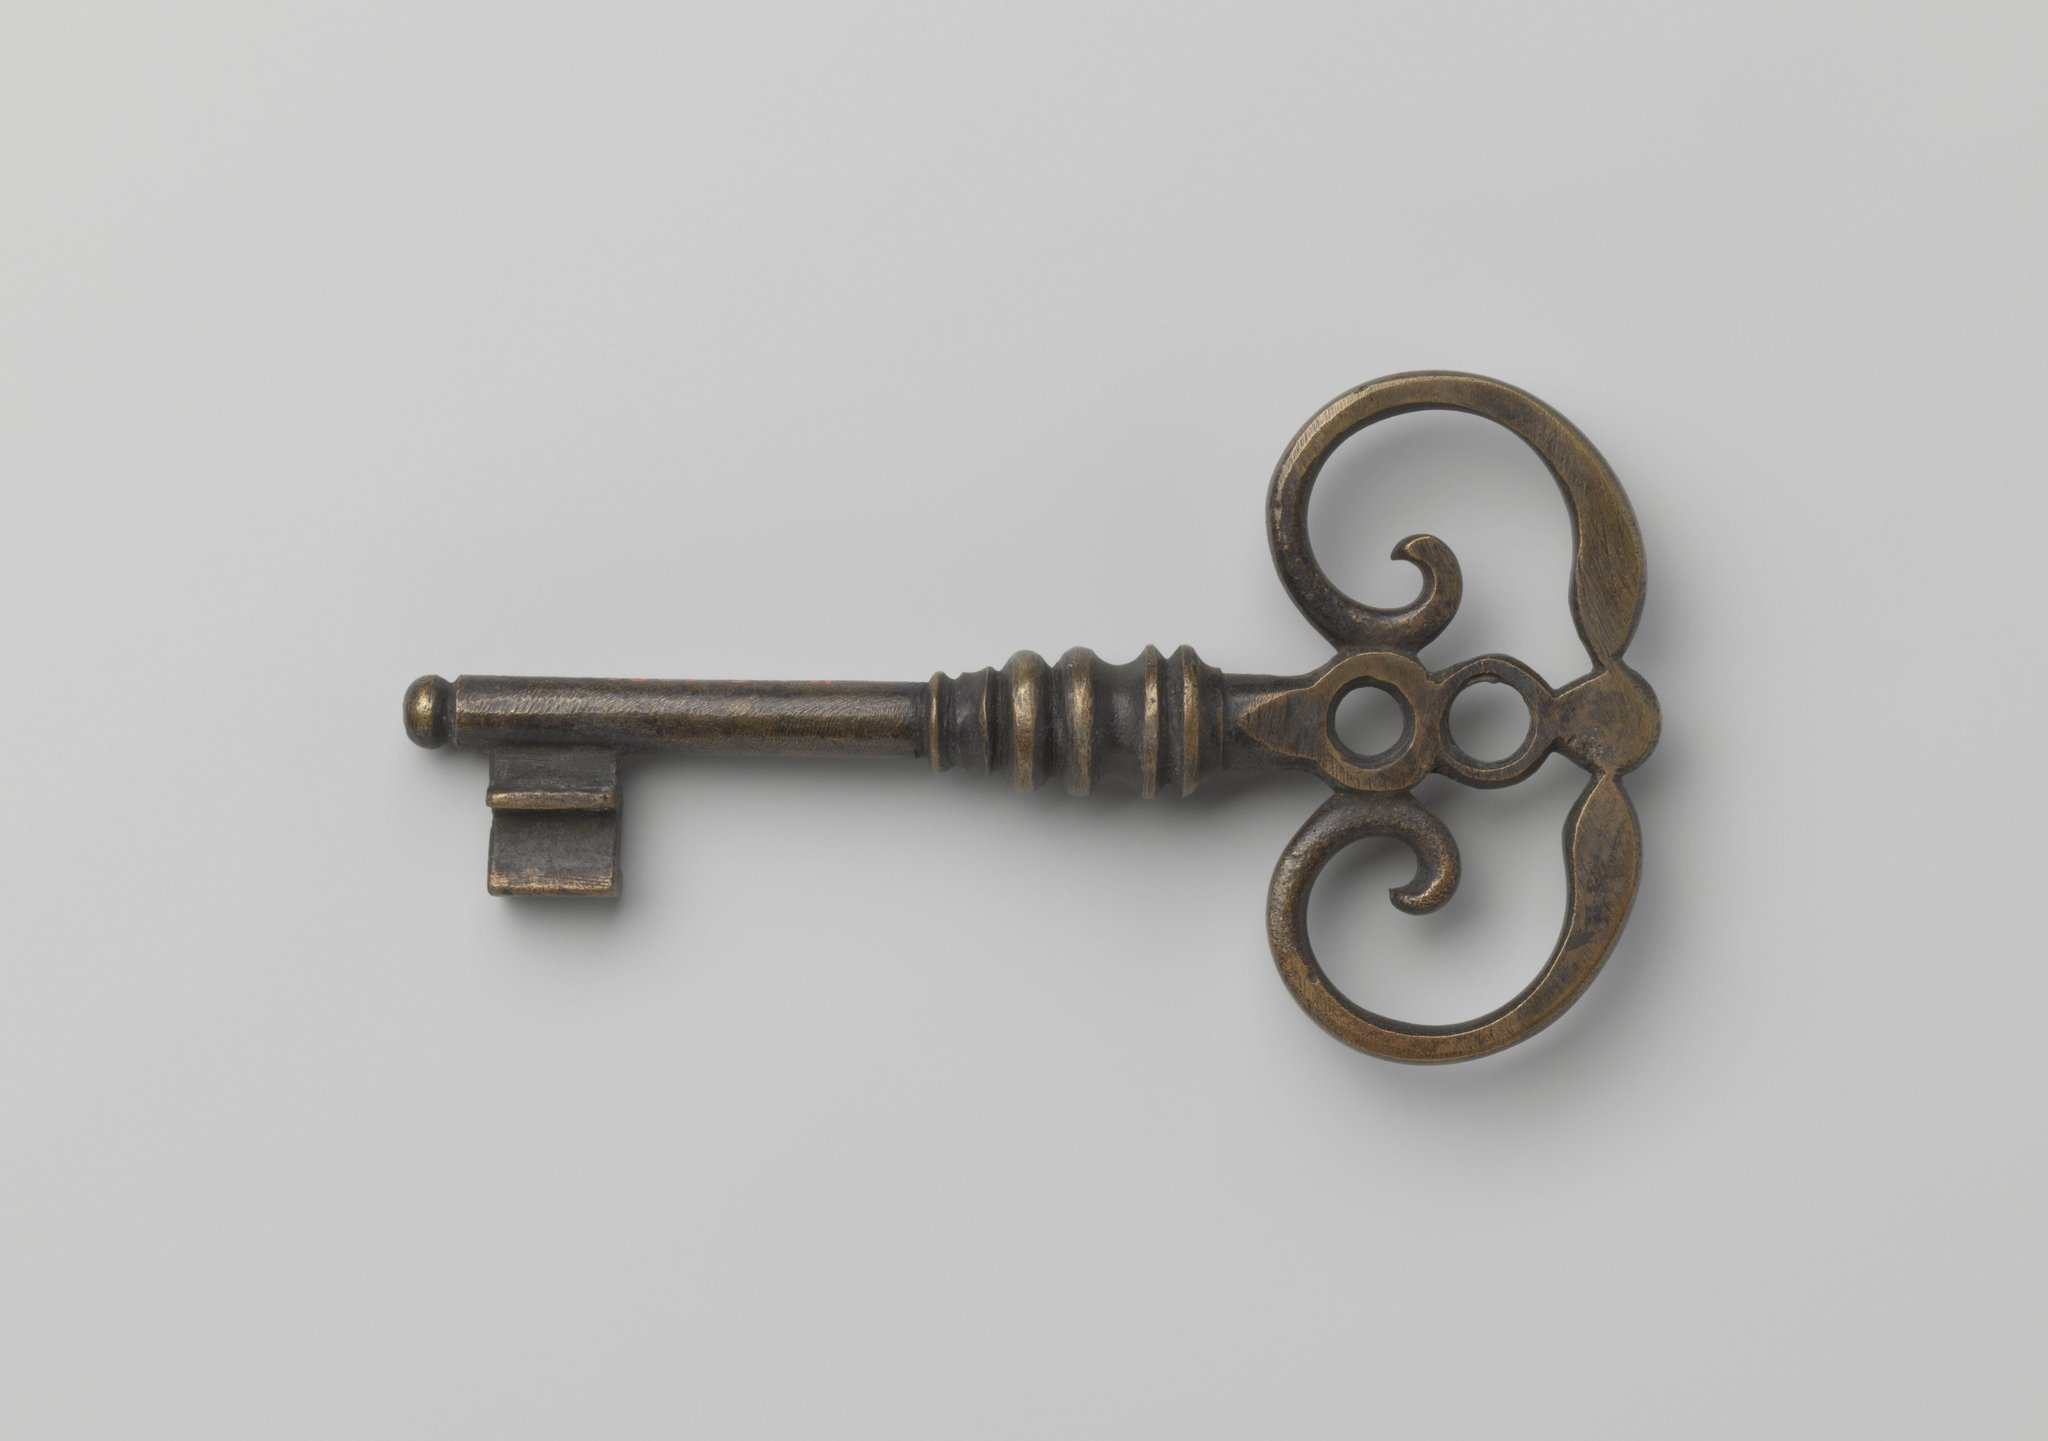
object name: key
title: Sleutel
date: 1700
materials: copper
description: Sleutel waarvan de greep uit twee naar beneden gewende voluten bestaat, waartussen zich twee boven elkaar geplaatste ogen bevinden. Het kapiteel is langgerekt en bestaat uit verschillende dikke en dunne schijven en eindigt onderaan in een knopje. De baard is Z-vormig.